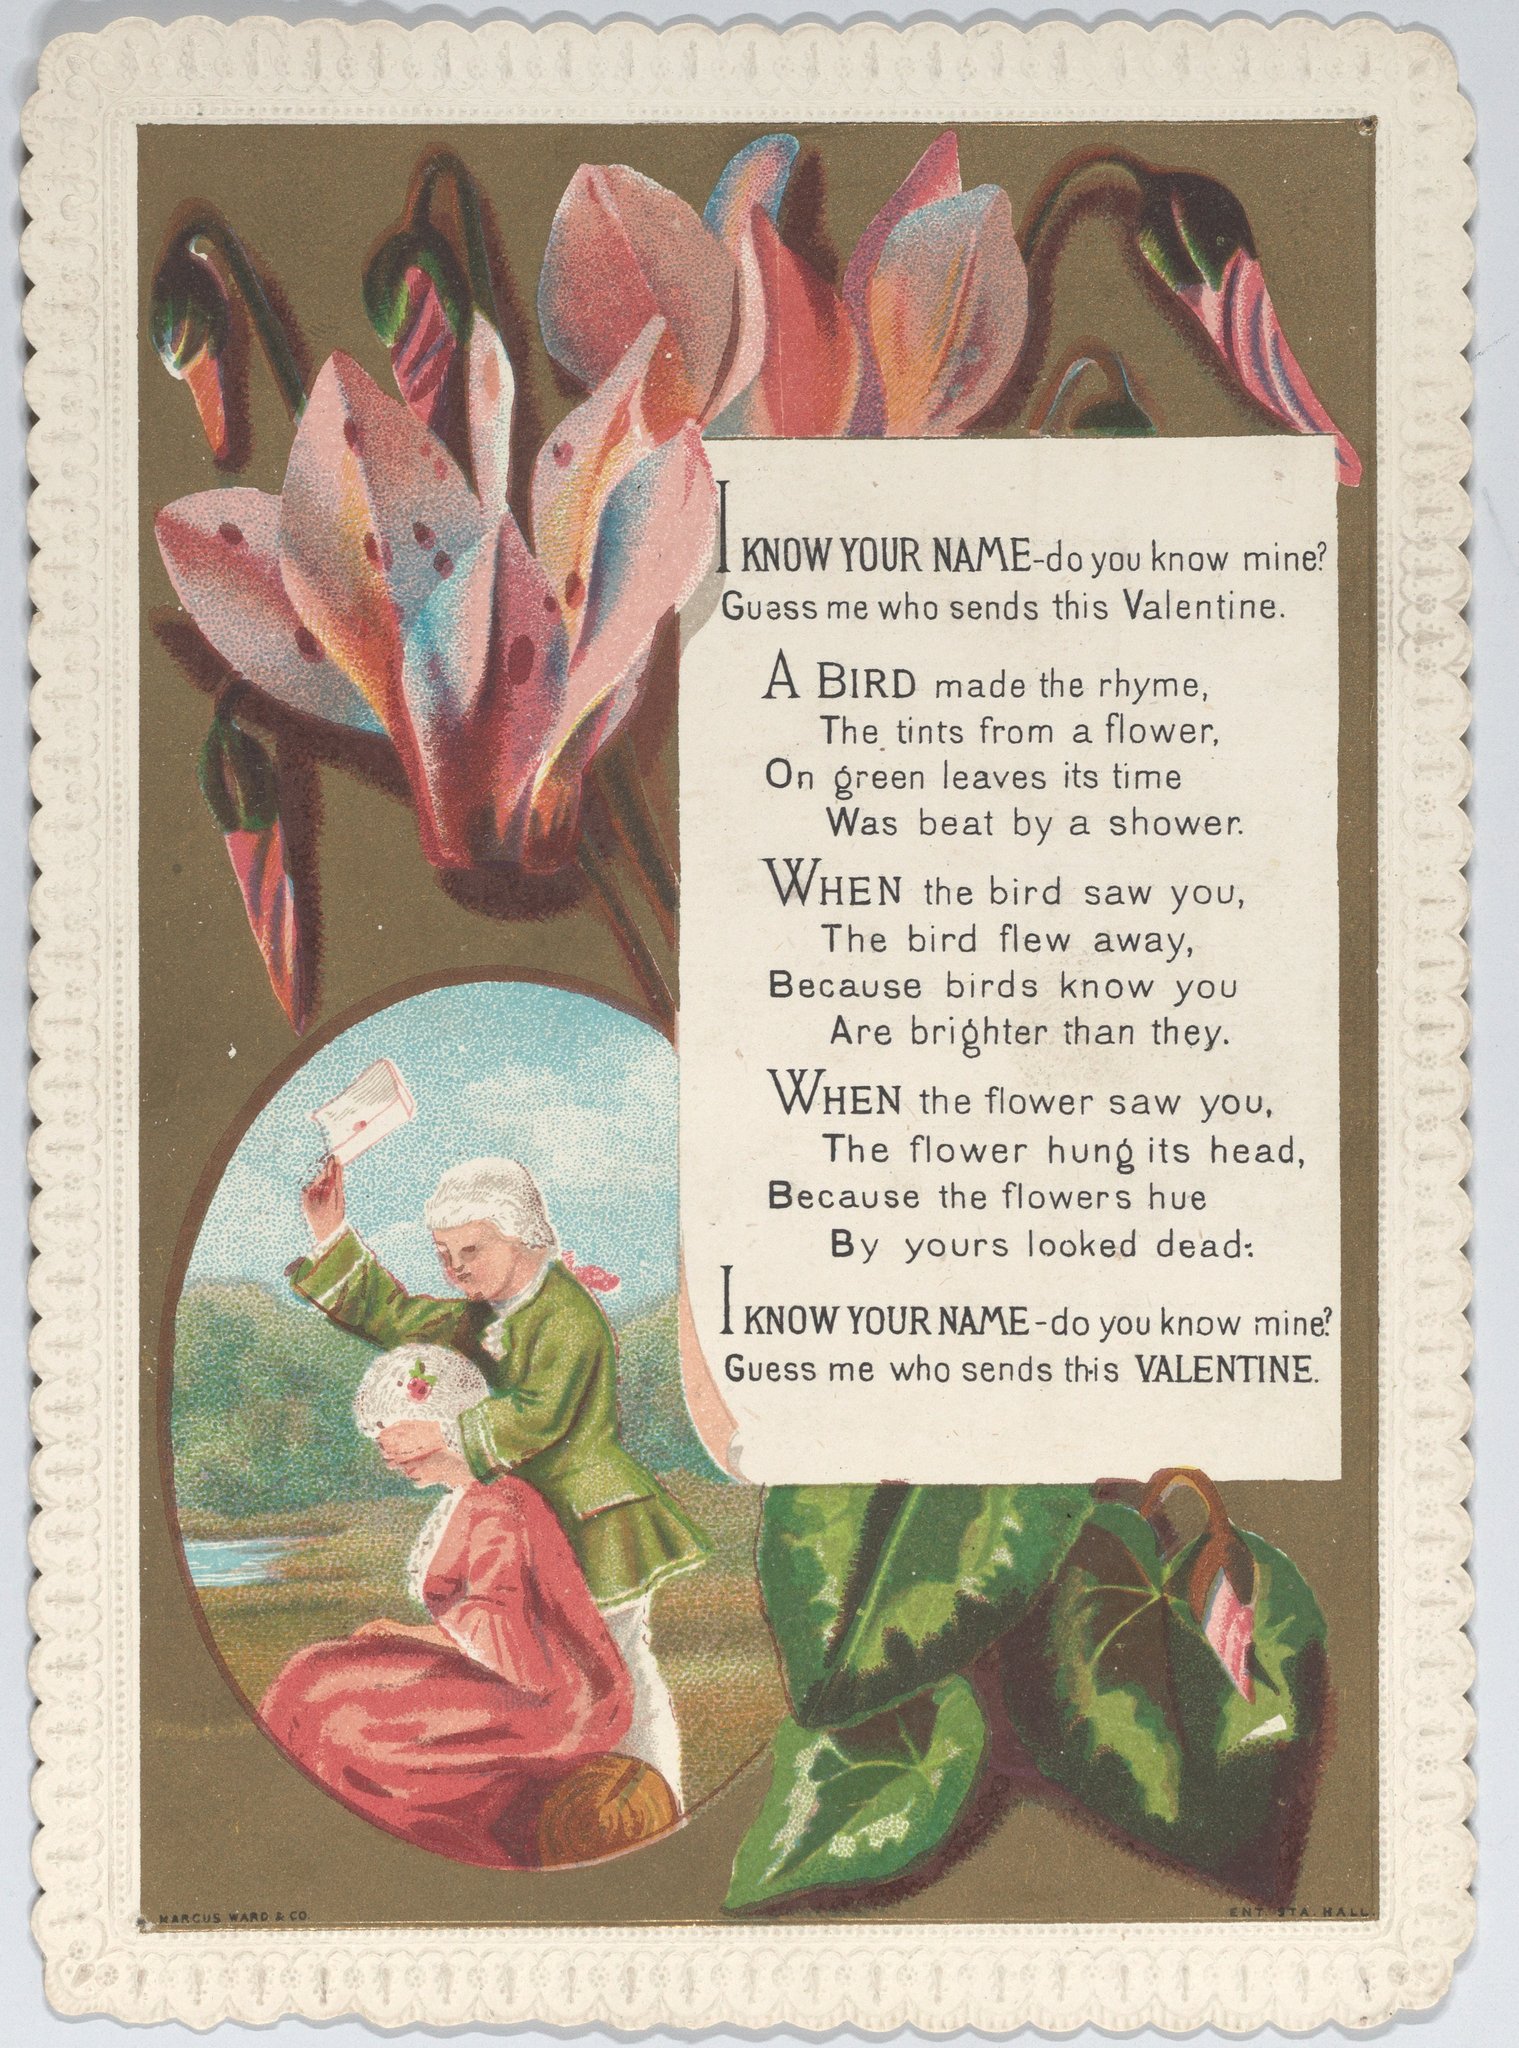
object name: valentine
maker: kate greenaway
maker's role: artist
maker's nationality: british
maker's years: 1846-1901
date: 1874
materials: gold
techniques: chromolithography, embossing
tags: poetry,couples,men,women,flowers